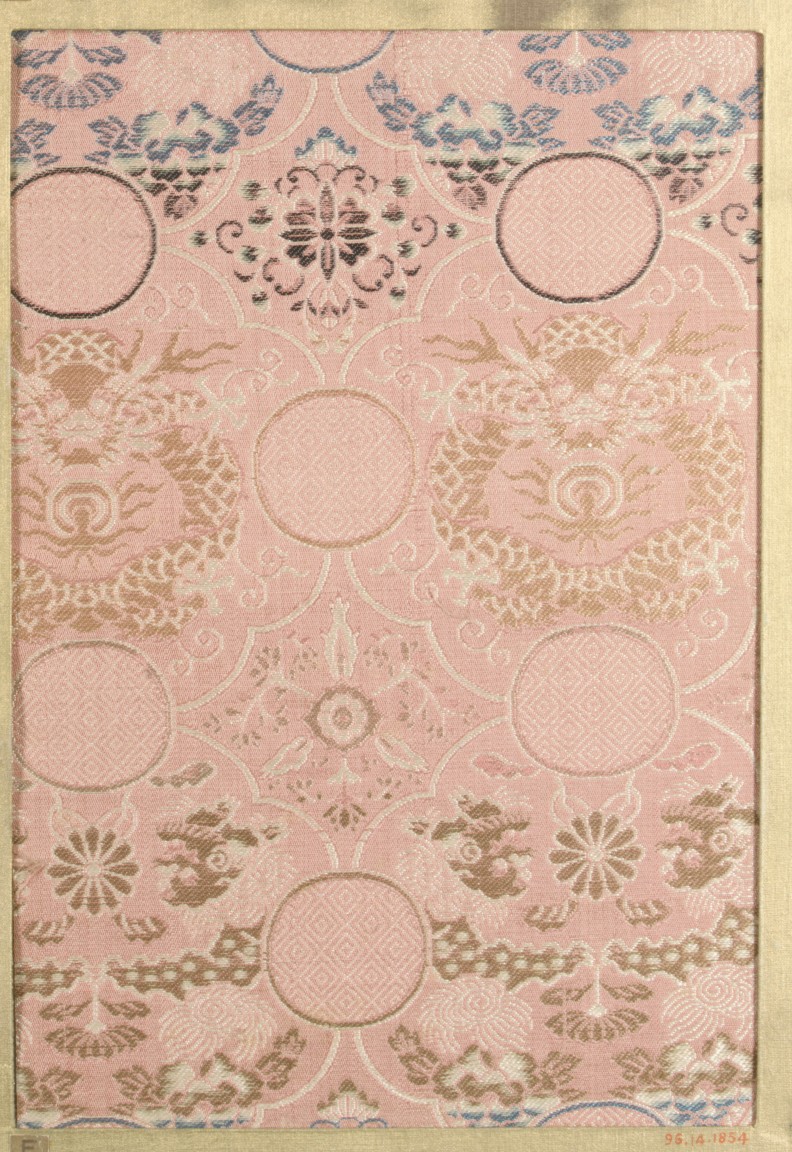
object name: piece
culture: japanese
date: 1701-1900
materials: silk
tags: dragons,flowers